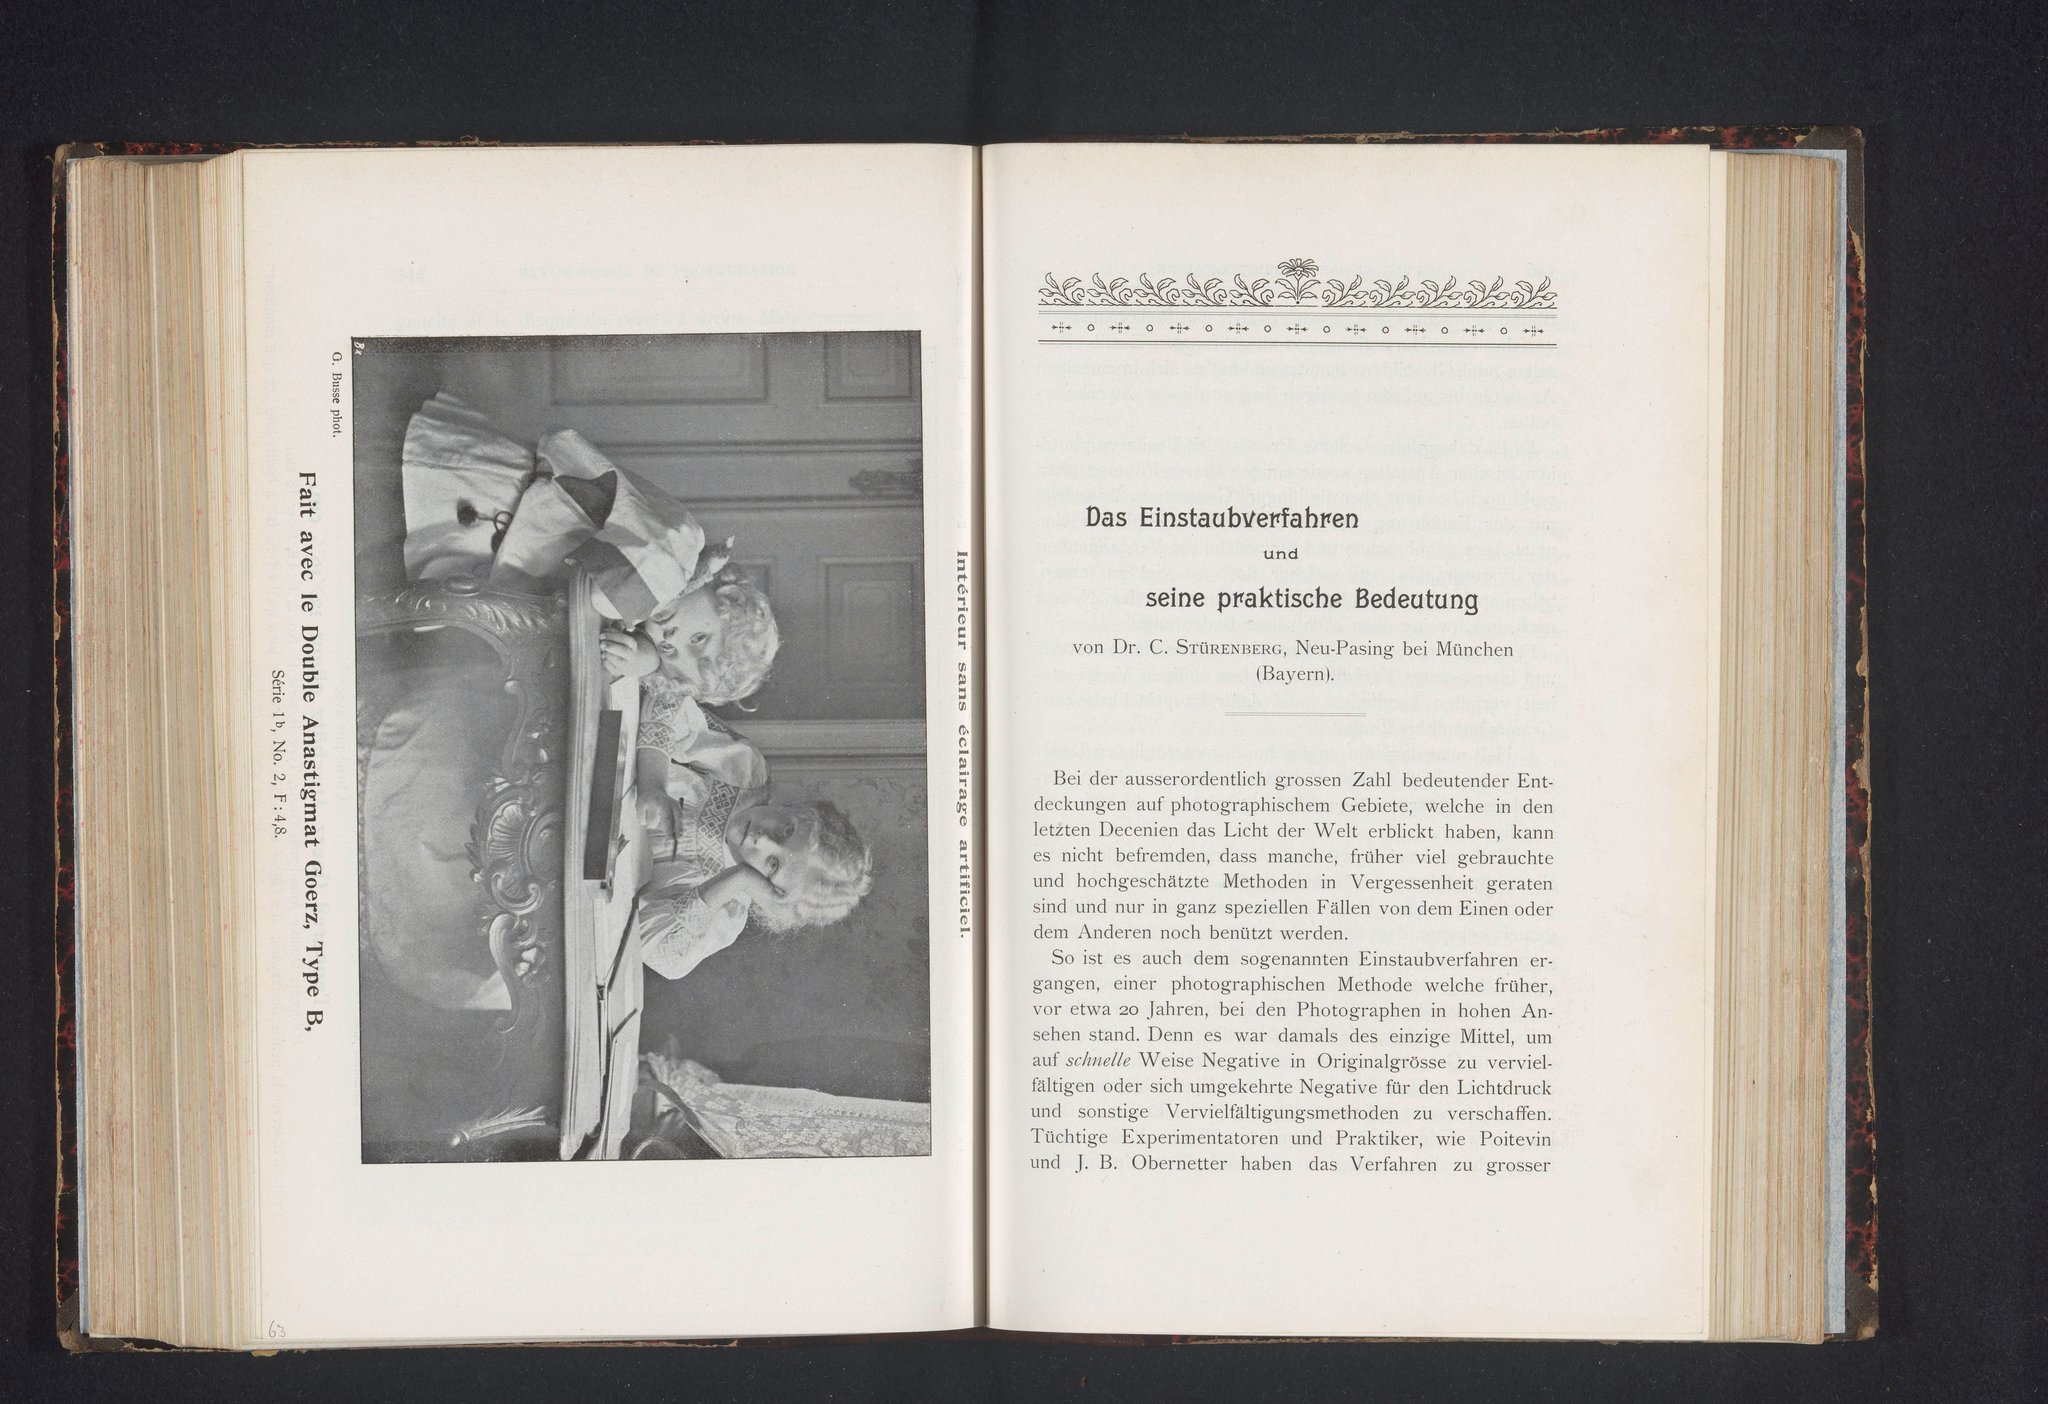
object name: page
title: Intérieur sans éclairage artificiel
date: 1897-1902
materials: paper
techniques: autotype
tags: writing-table, writing-desk, girl (child between toddler and youth)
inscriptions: inscription: ‘Fait avec le Double Anastigmat Goerz, Type B (...)’, monogram: ‘BX’